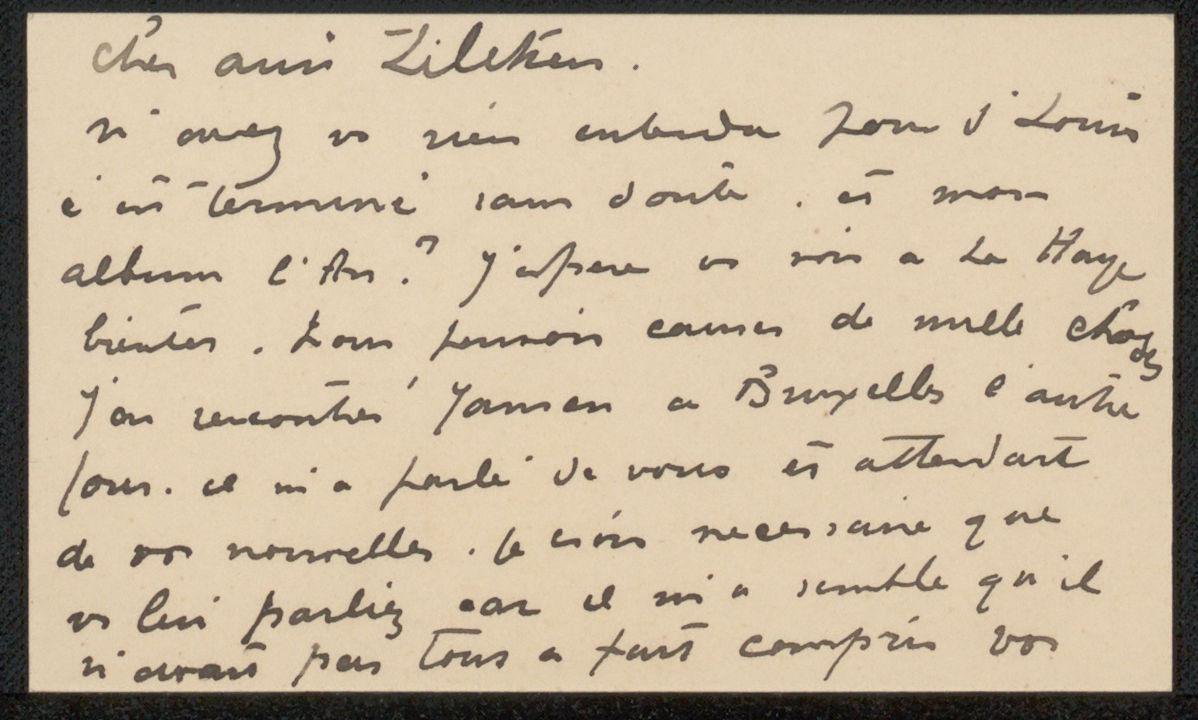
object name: visiting card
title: Visitekaartje aan Philip Zilcken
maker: franz melchers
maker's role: draughtsman, painter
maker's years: 1868-1944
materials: cardboard, ink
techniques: pen, printing, writing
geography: baarn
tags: the hague, draughtsman, philip zilcken, artist at work, in his workshop - bb - out of doors, brussels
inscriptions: collector's mark: ‘RPK’